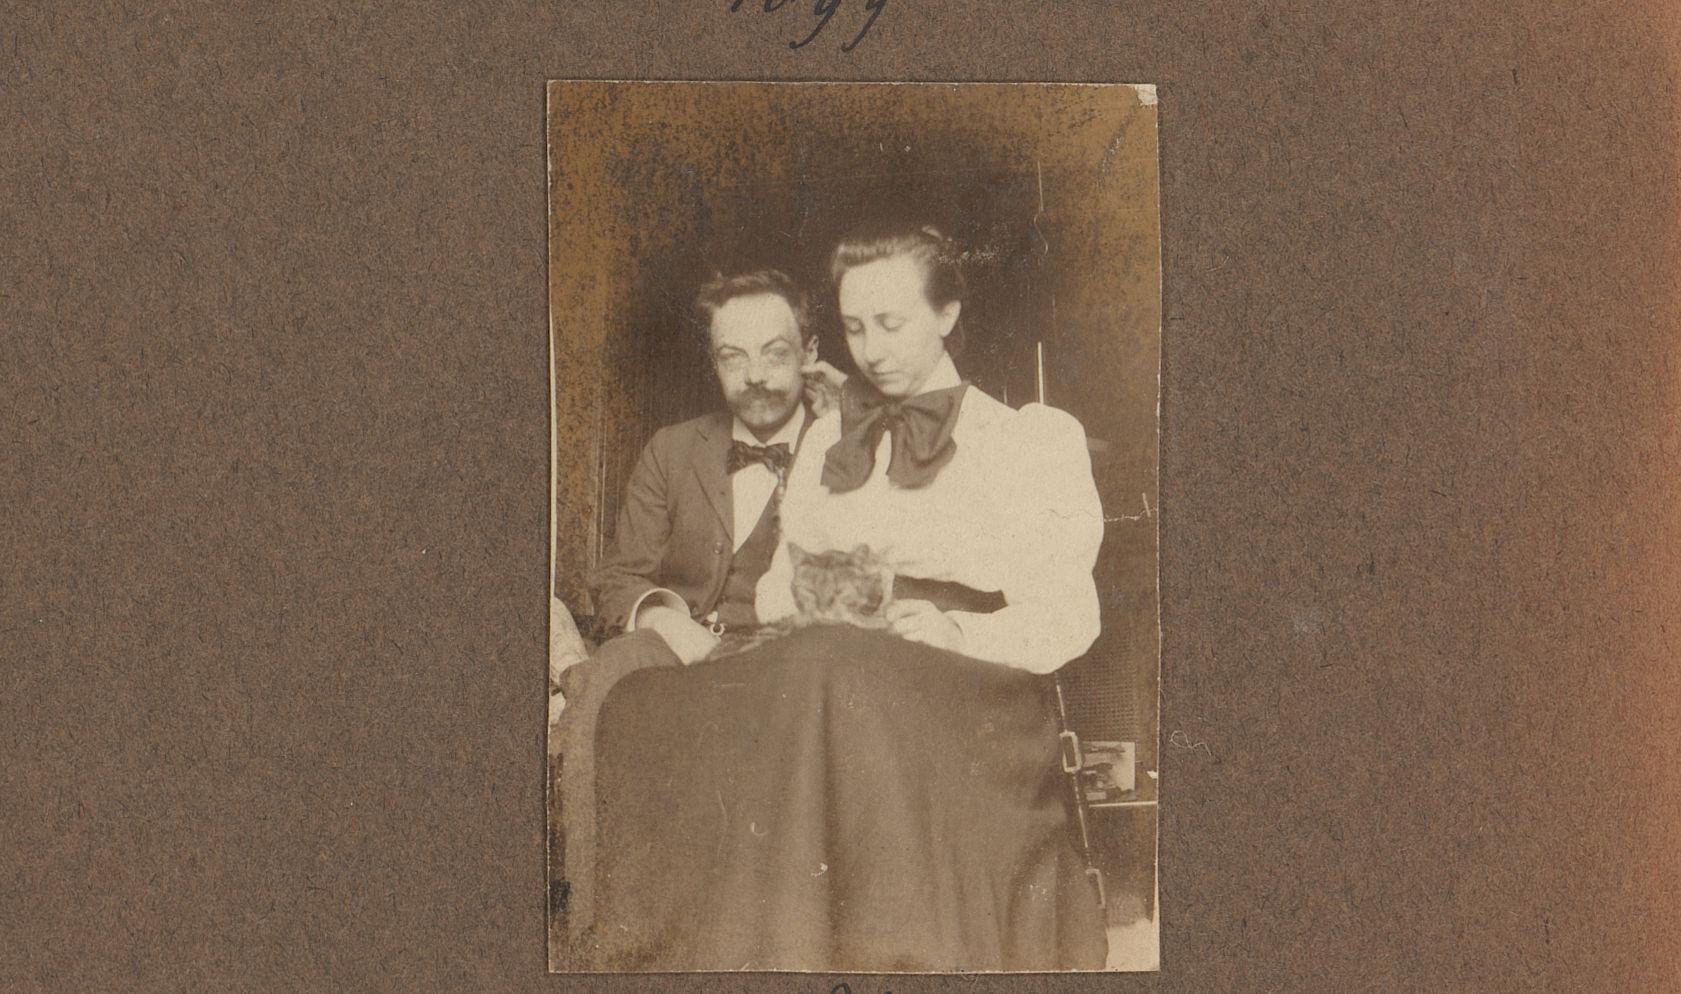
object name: photograph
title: Alphons Diepenbrock en echtgenoot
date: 1899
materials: photographic support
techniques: photography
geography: netherlands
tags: amsterdam, alphons diepenbrock, jonkvrouw wilhelmina elisabeth petronella cornelia de jong van beek en donk, netherlands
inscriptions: inscription: ‘1899’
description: Foto op bruin albumblad 23 van familiealbum van Alphons Diepenbrock.